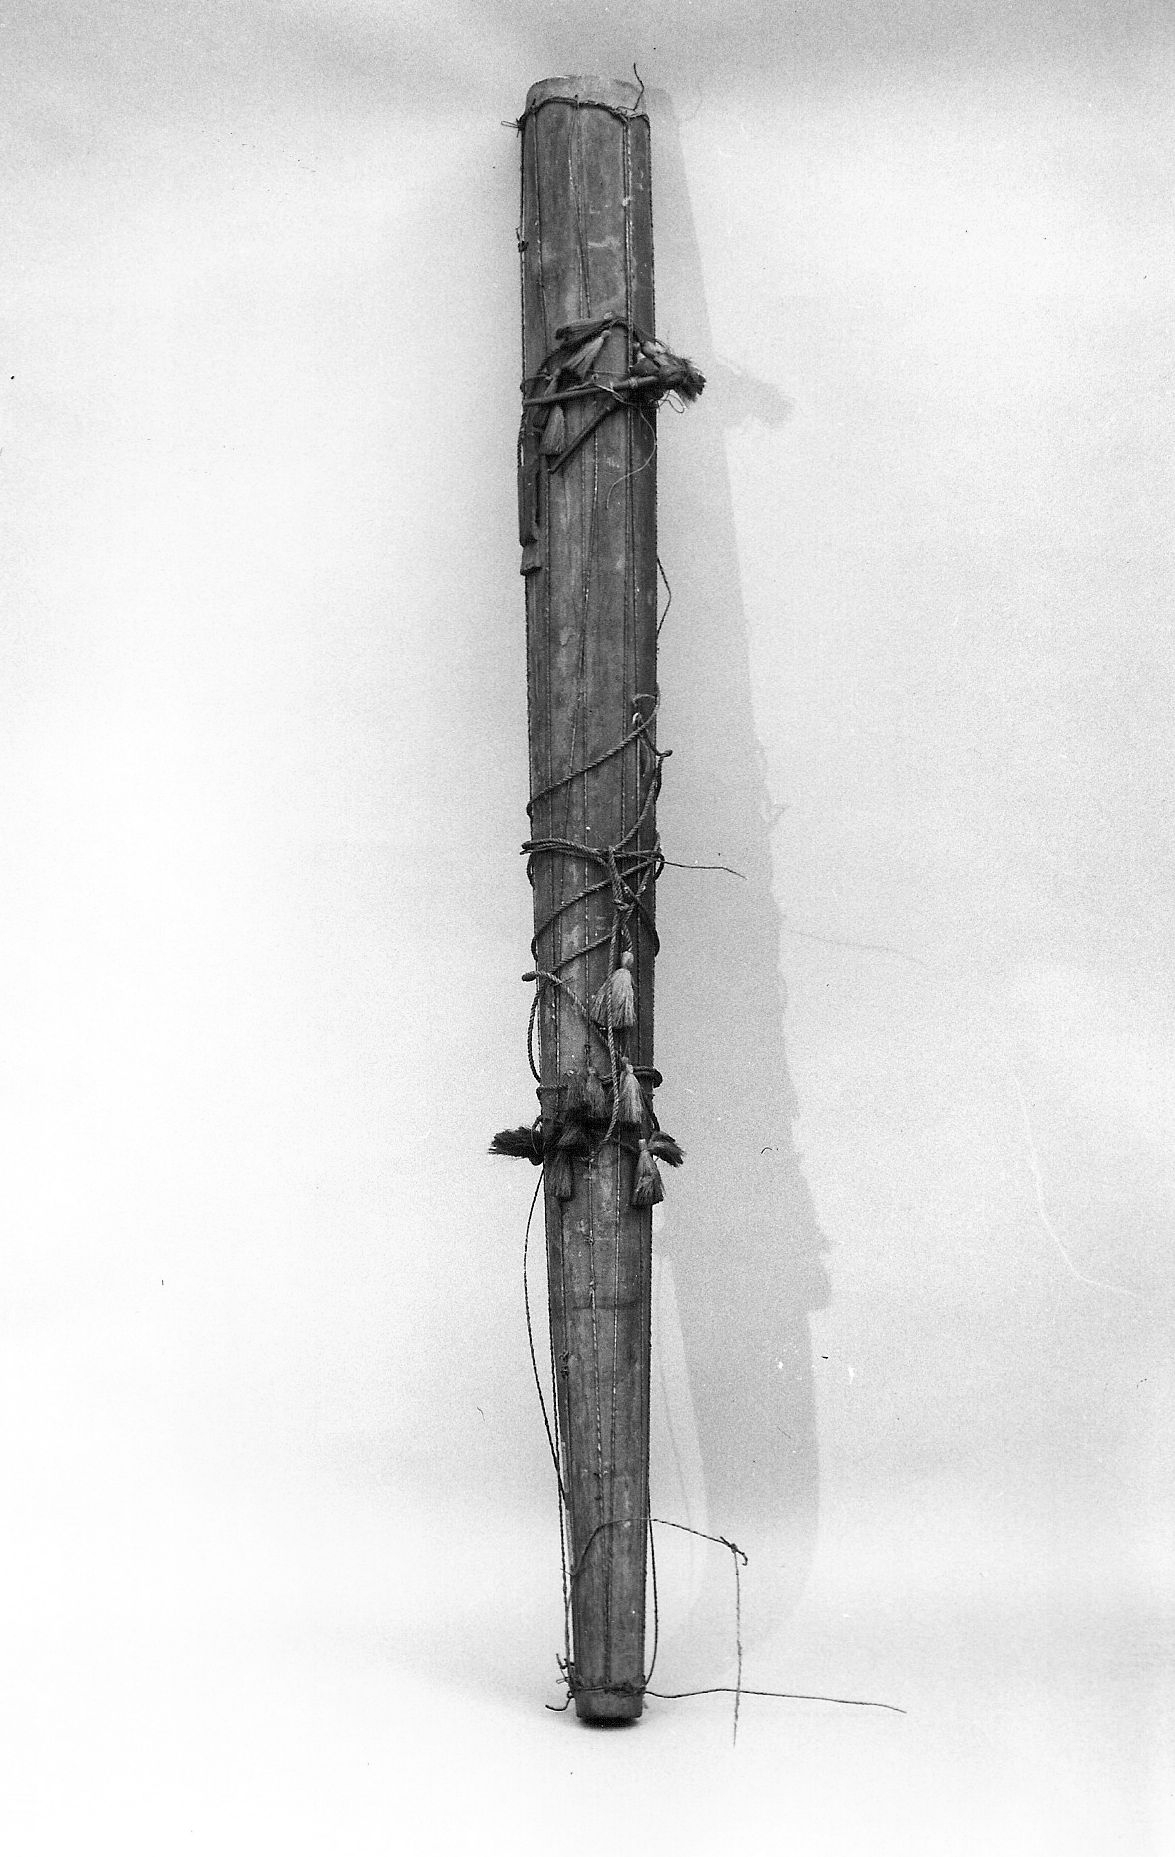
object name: ndungu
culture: kondo or yembe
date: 1801-1900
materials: fiber, wood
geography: congo